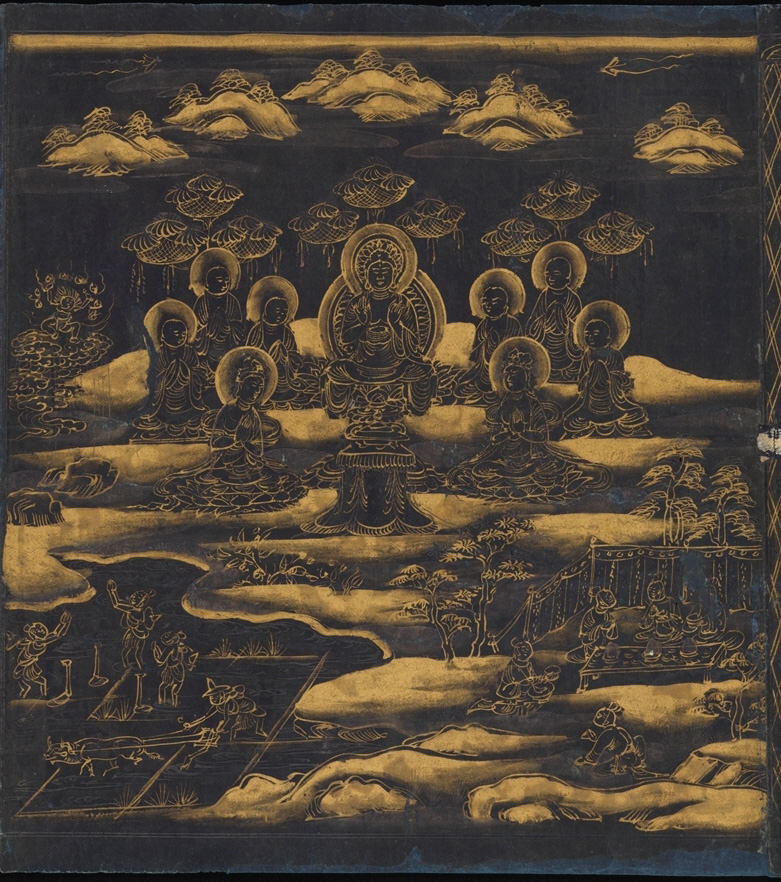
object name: handscroll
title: “Parable of the Medicinal Herbs” (Yakusōyu), Chapter 5 of the Lotus Sutra (Saddharma pundarika)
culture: japanese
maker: unidentified artist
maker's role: artist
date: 1101-1200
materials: gold, ink, paper, silver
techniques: dyeing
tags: herbs,buddhism,buddha